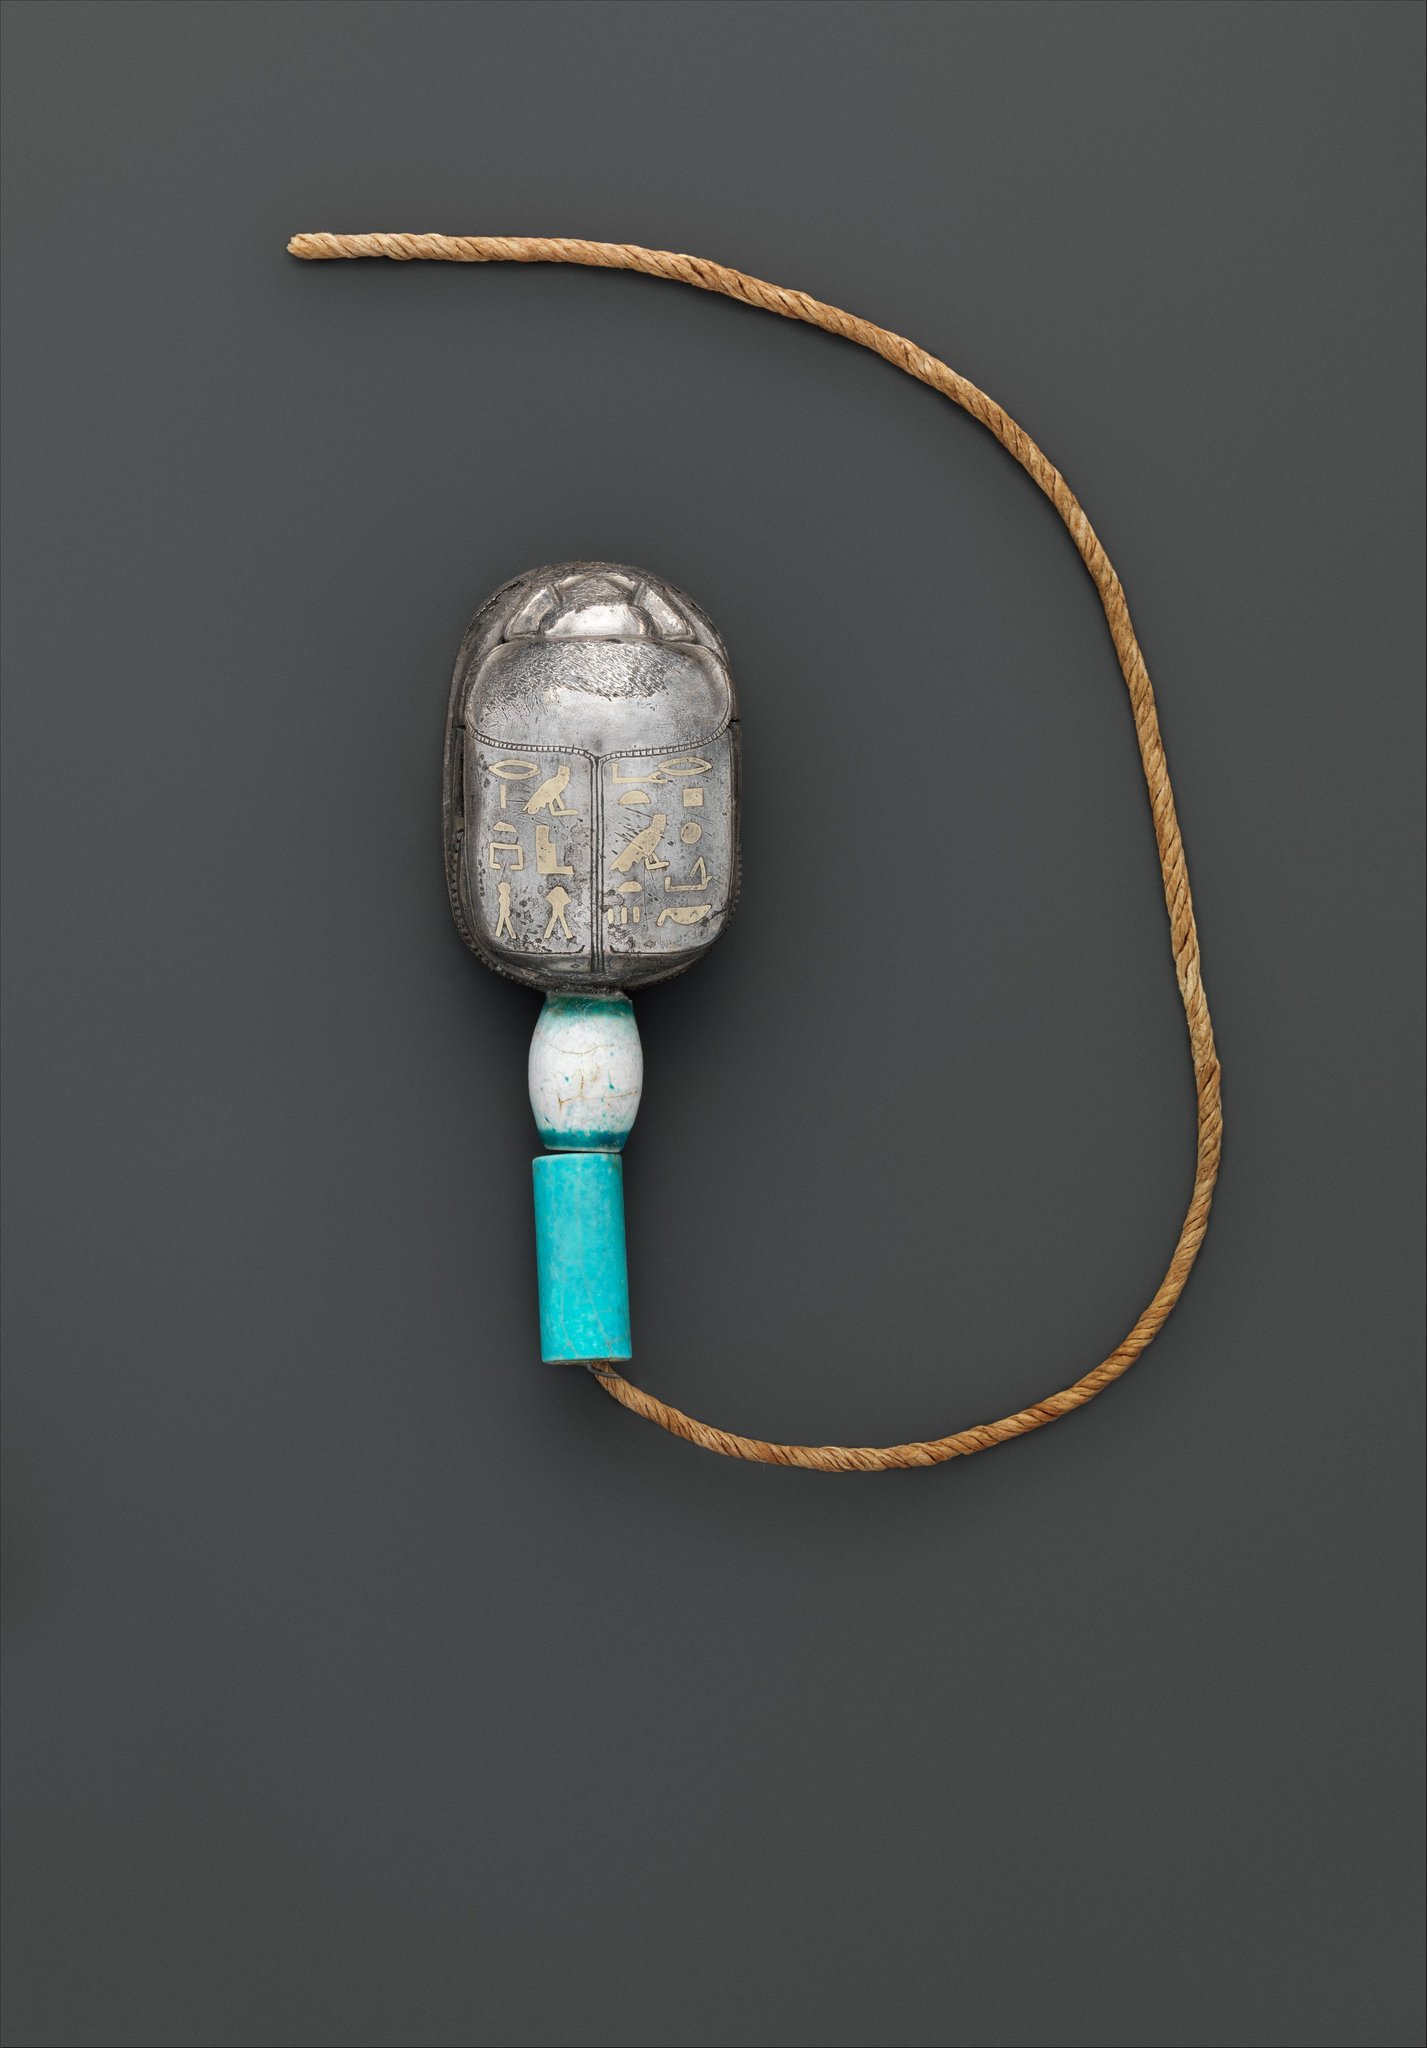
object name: scarab, bracelet, wah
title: Scarab of the Storehouse Overseer Wah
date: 1981-1975 BCE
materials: cord, linen, silver, stone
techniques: glazing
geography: egypt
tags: hieroglyphs